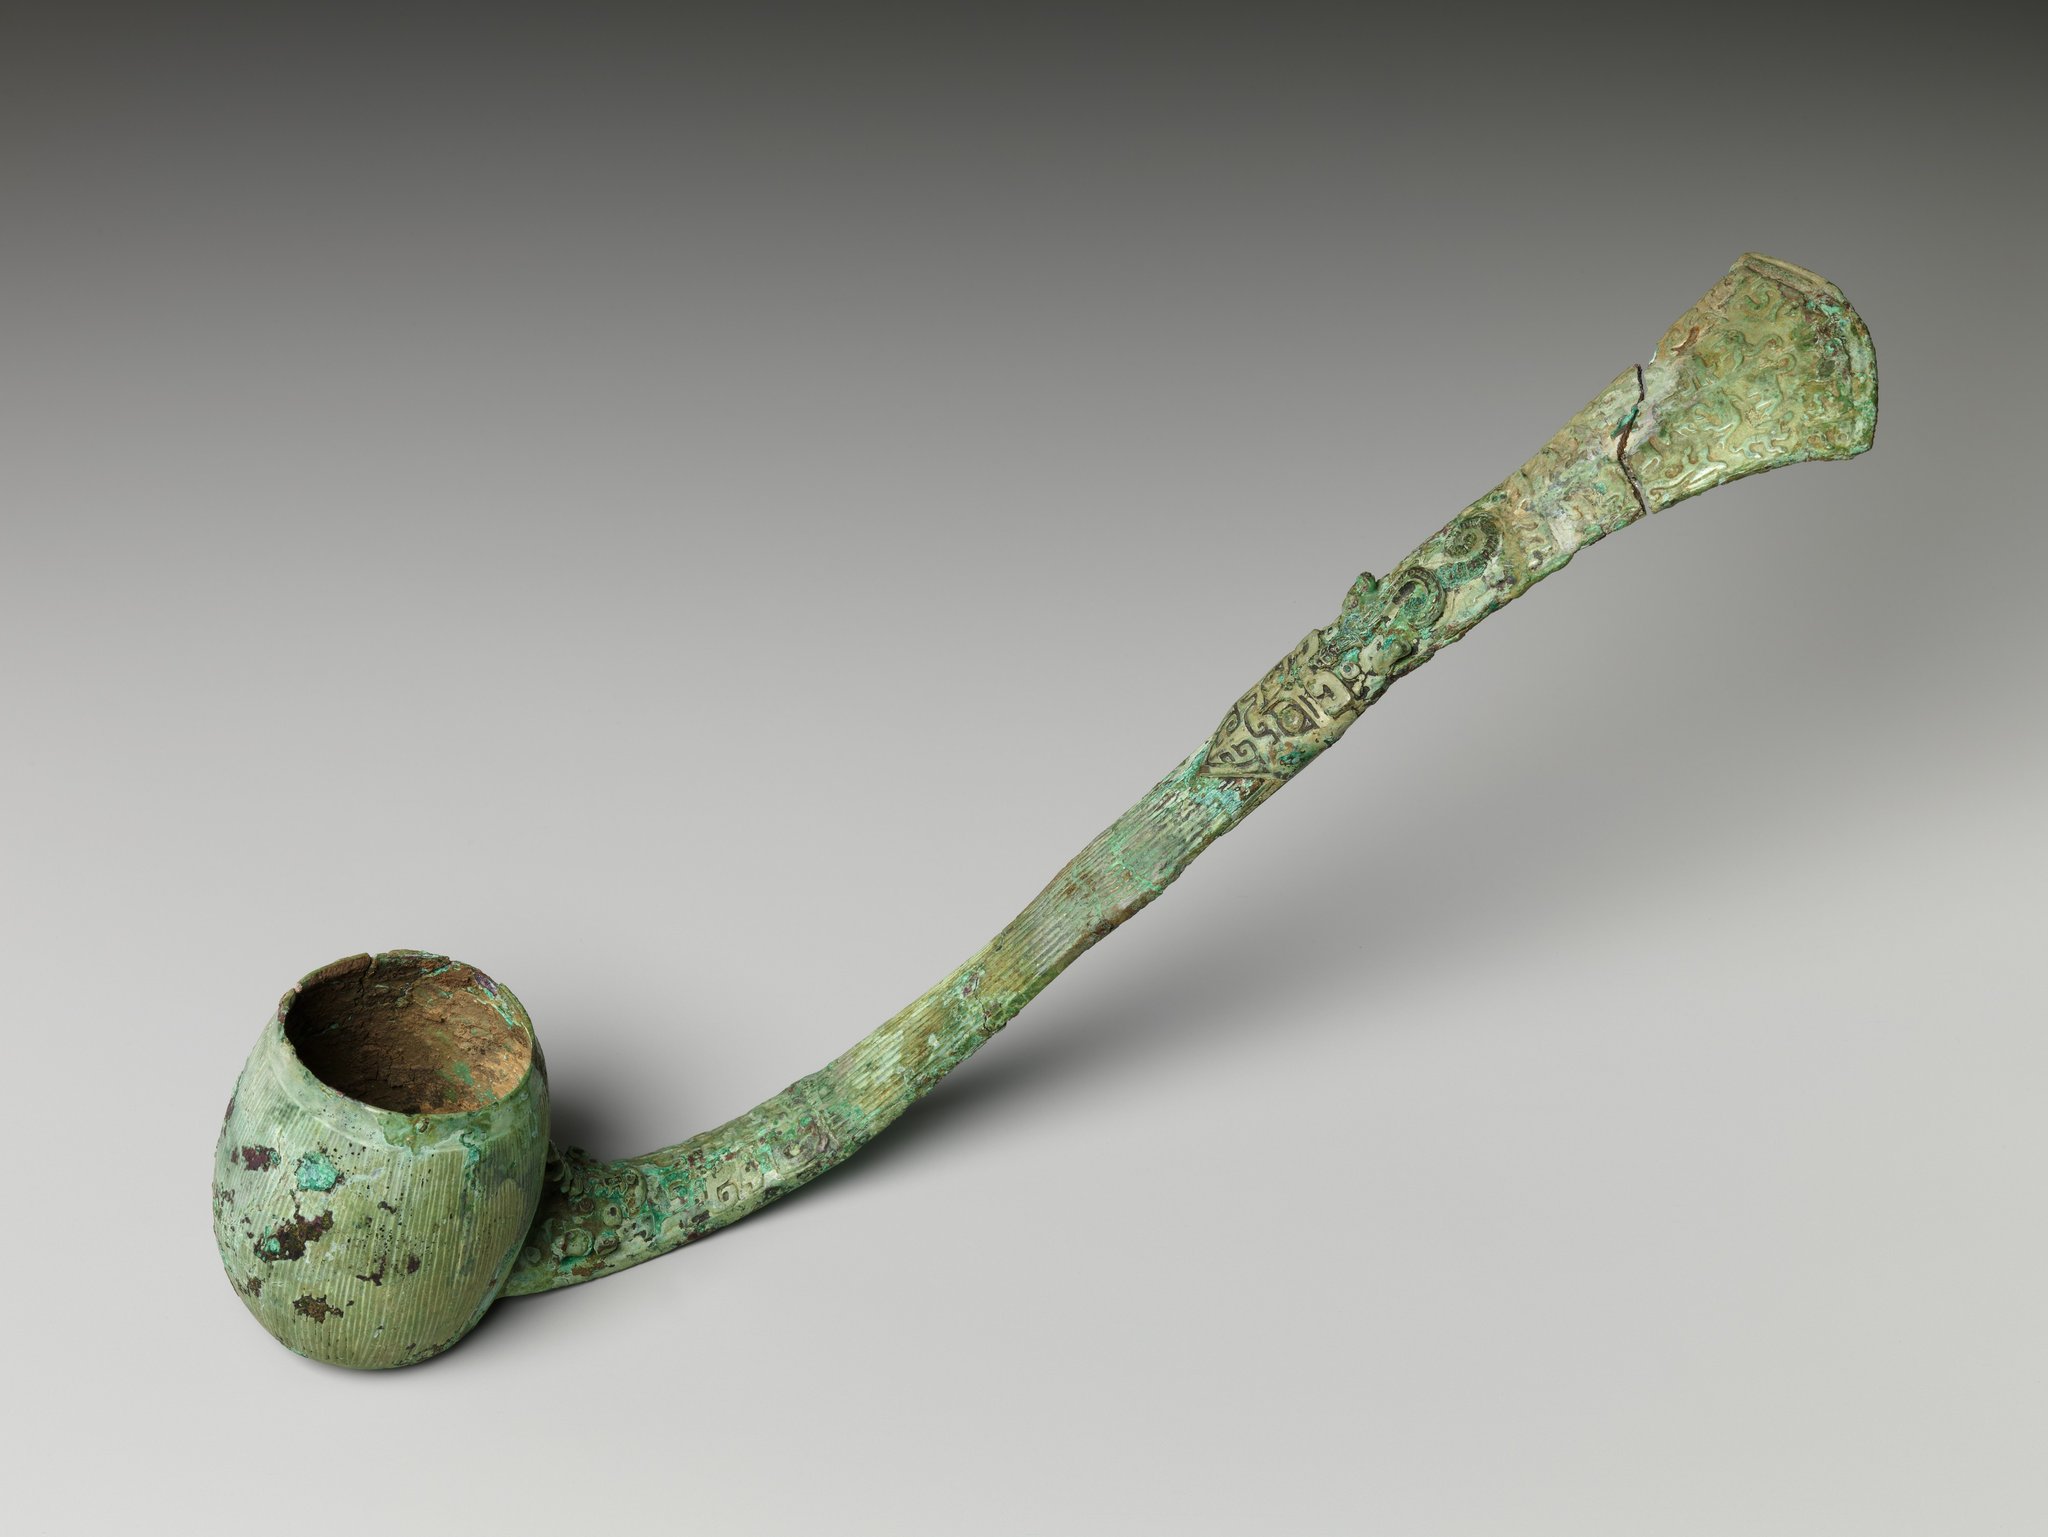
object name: wine ladle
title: Wine ladle (dou)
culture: chinese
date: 1200-1001 BCE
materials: bronze